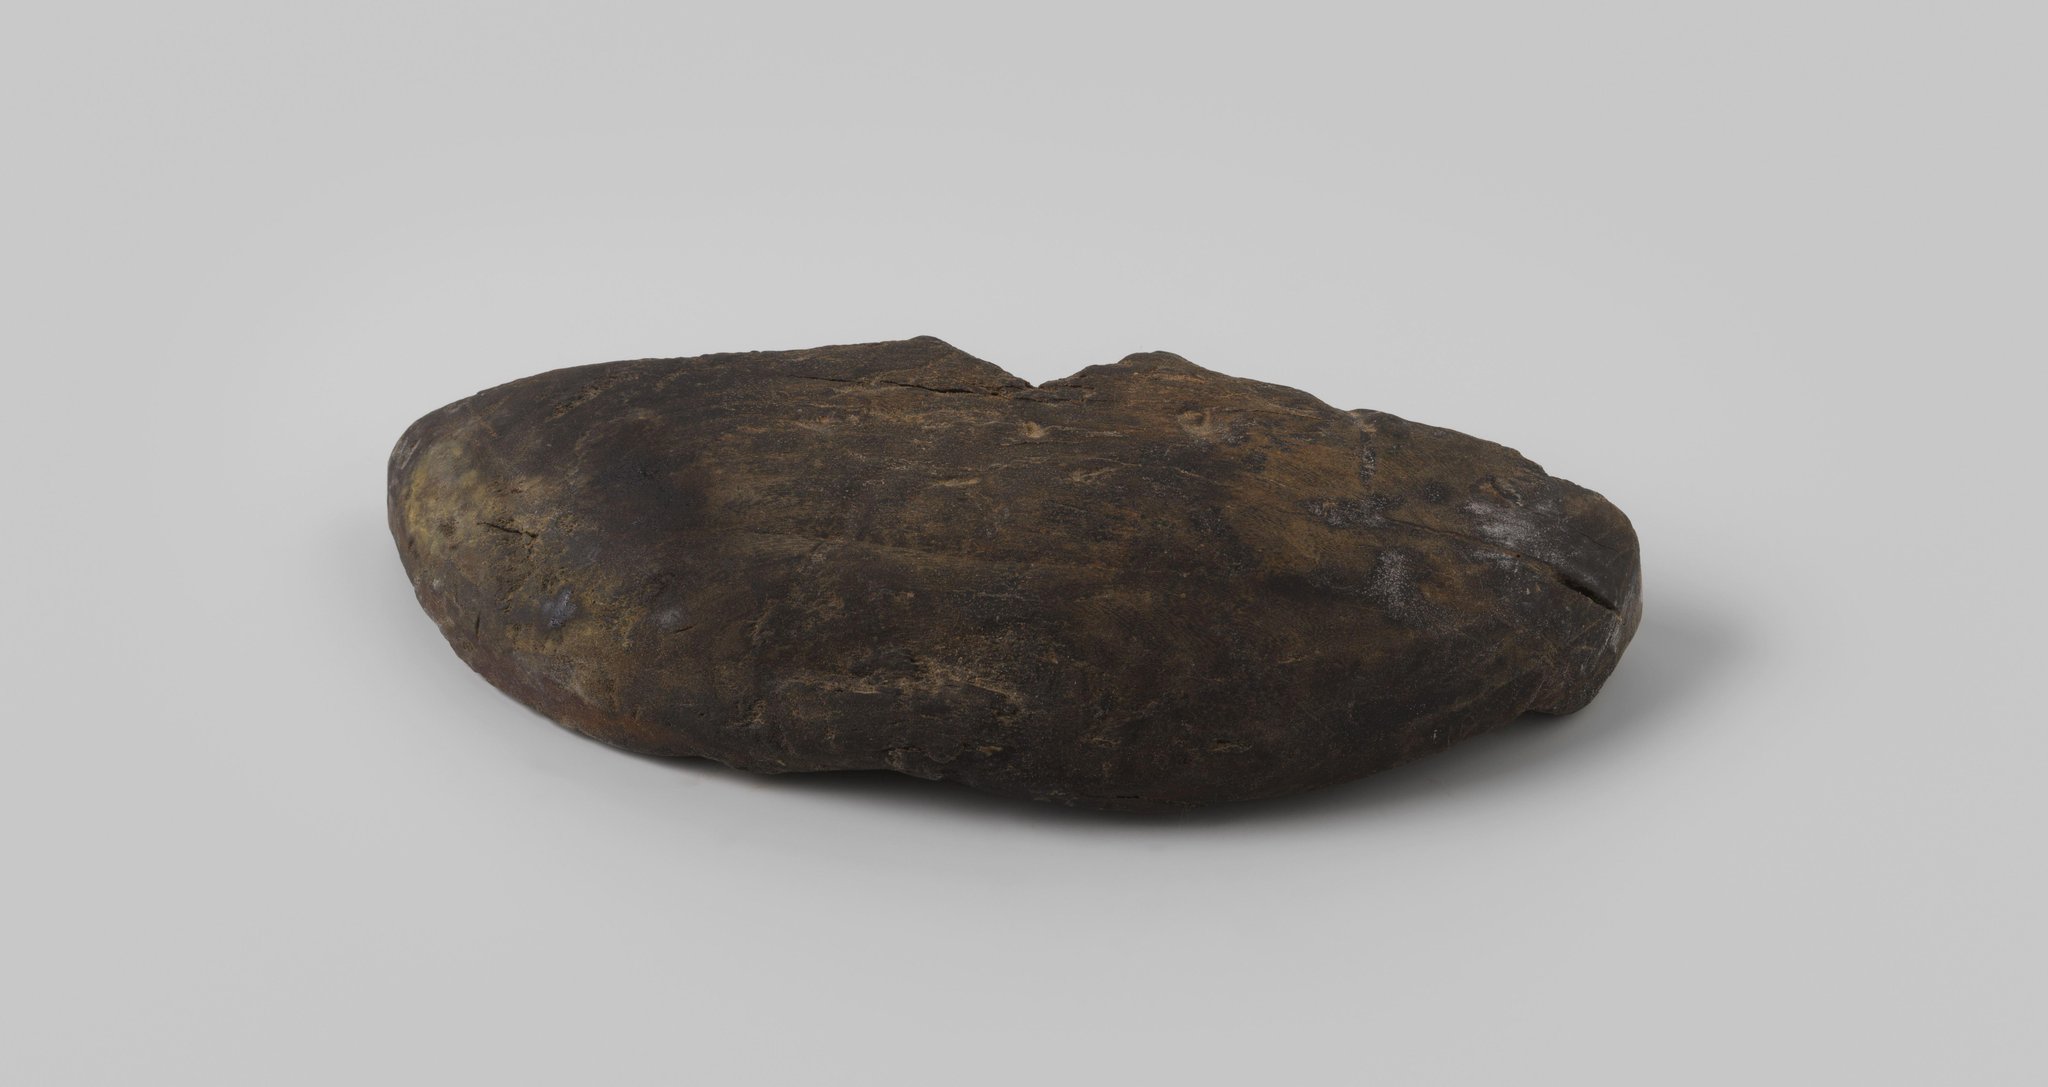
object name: disk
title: Fragment schijf uit de Oost-Indiëvaarder Hollandia.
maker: Anonymous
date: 1700-1743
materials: wood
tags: verenigde oostindische compagnie, hollandia (schip)